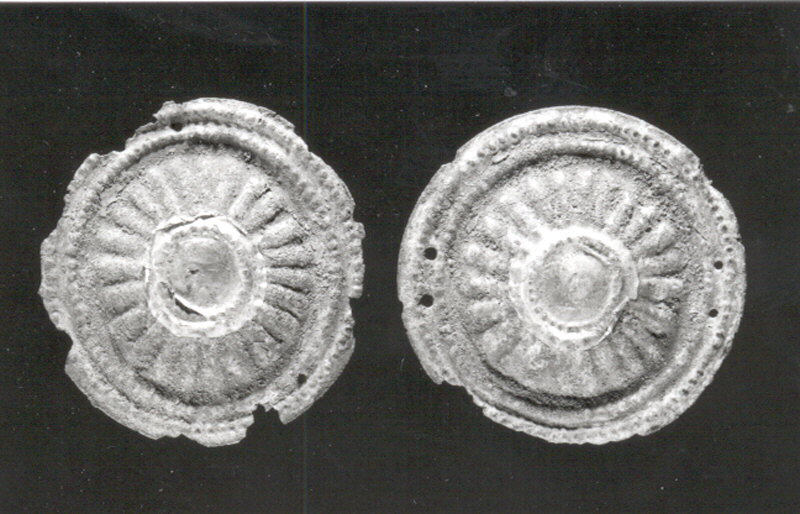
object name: disc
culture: iranian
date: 1000 BCE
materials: bronze, gold